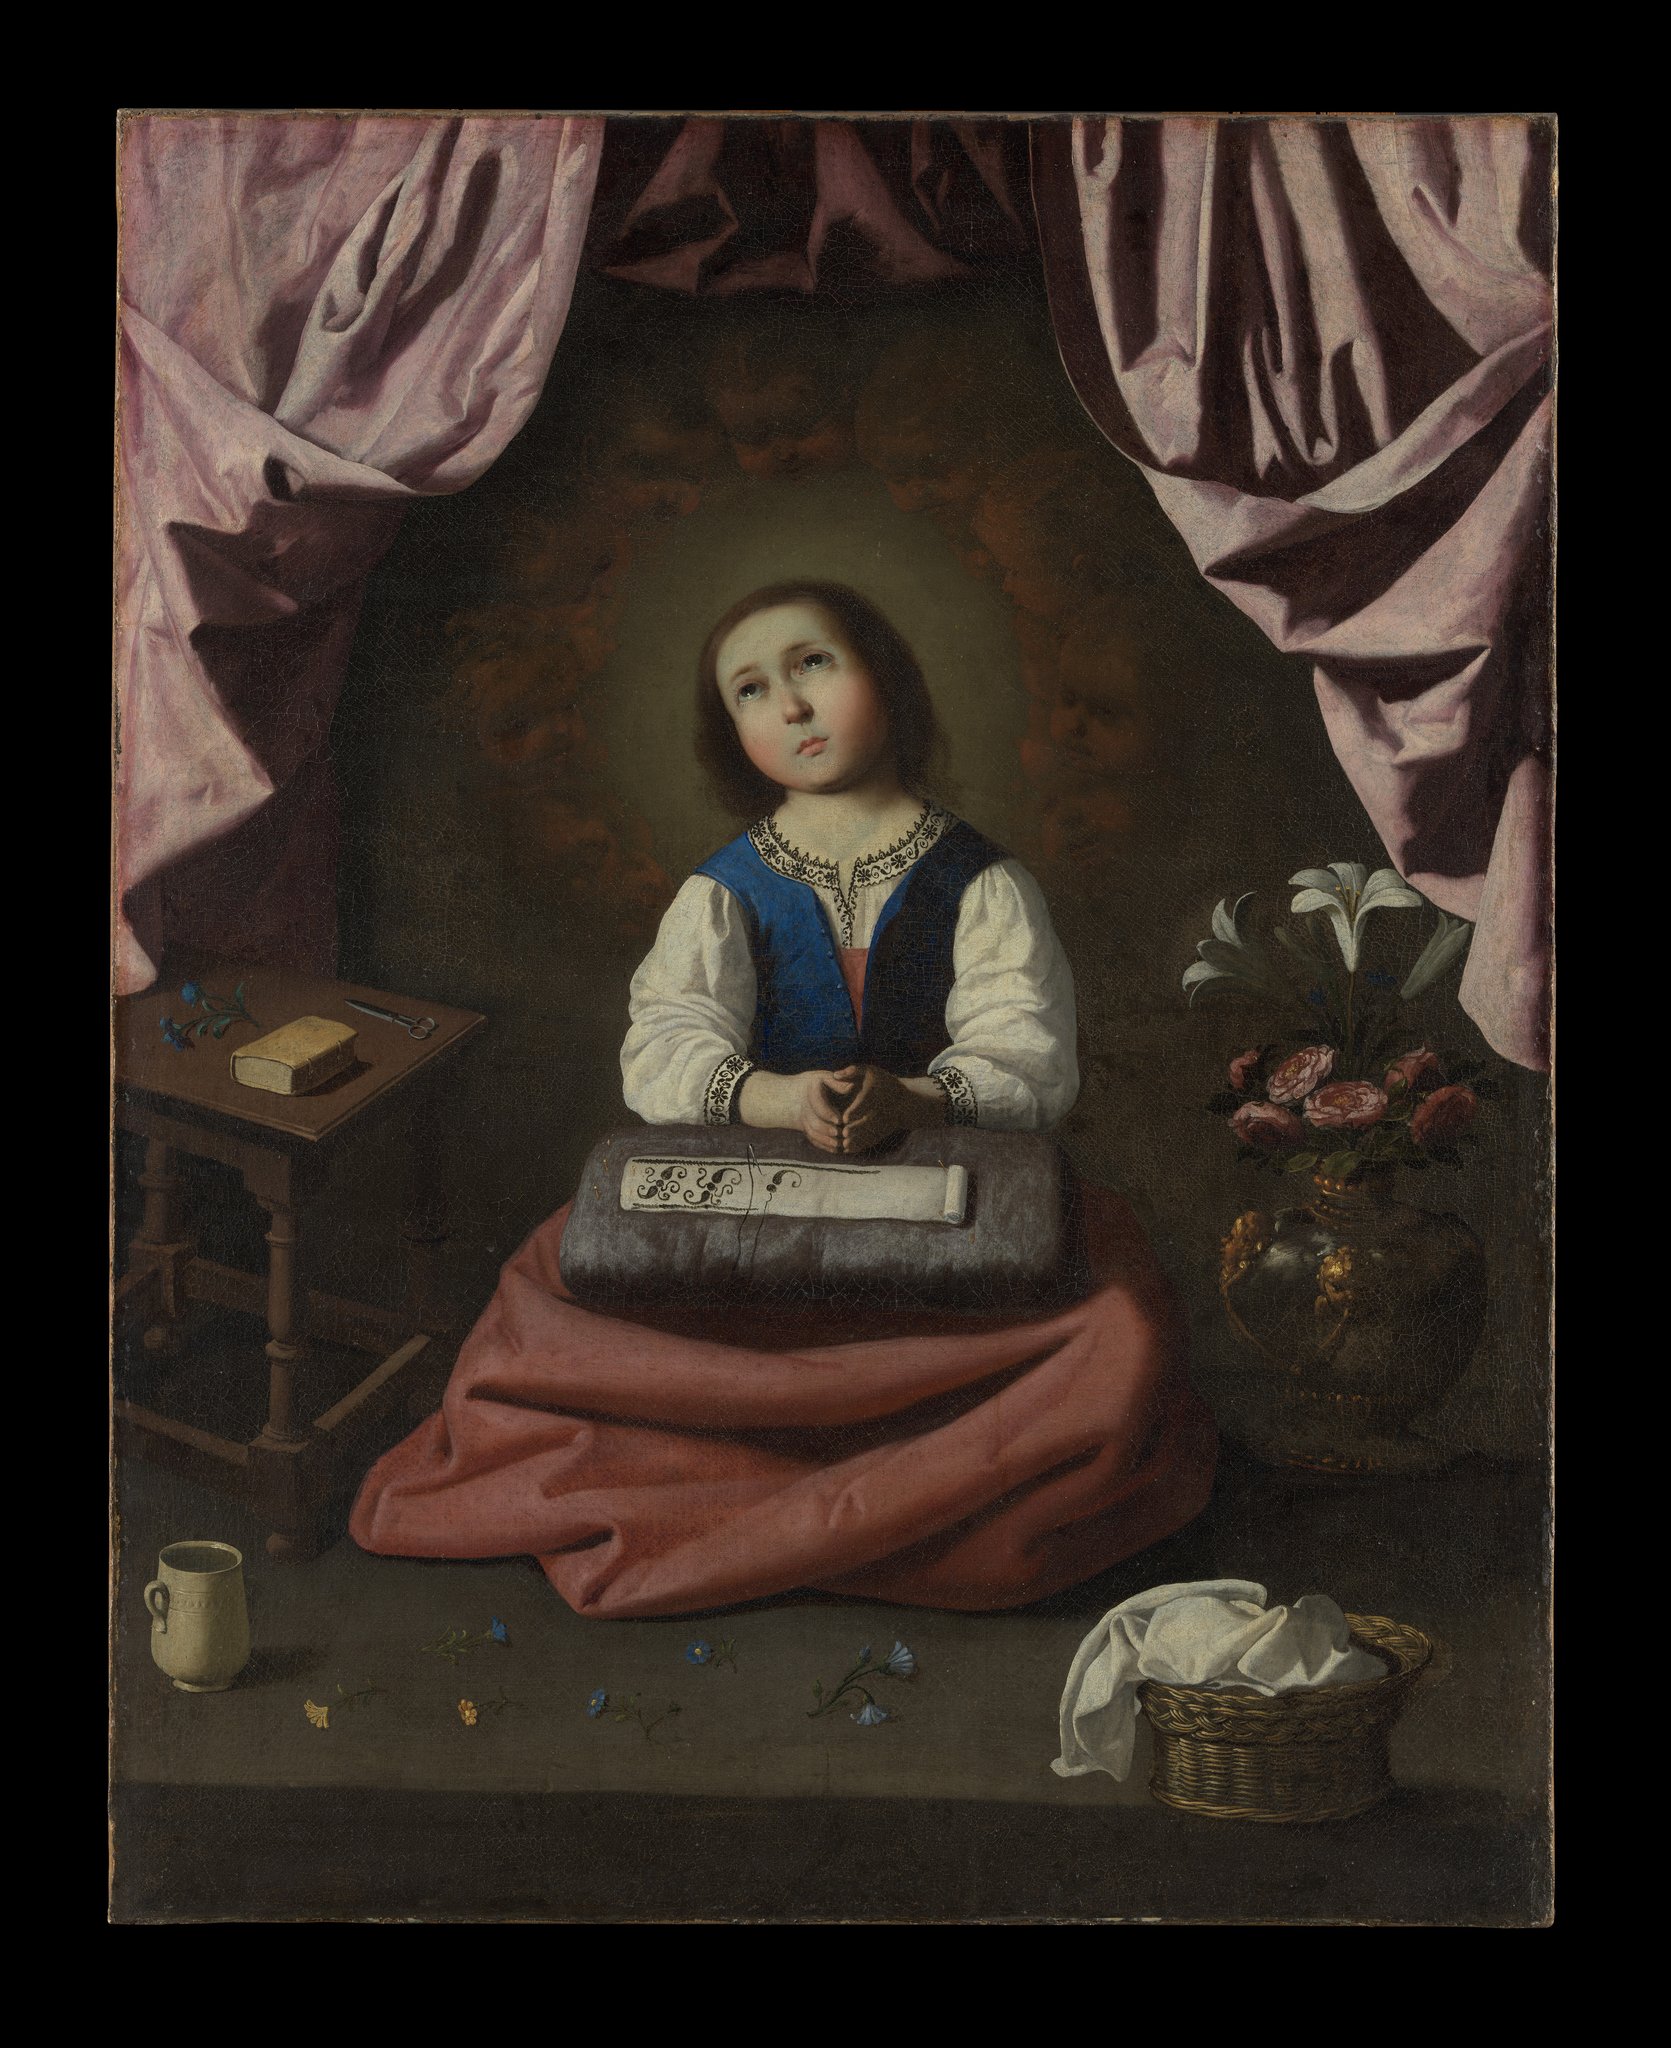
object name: painting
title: The Young Virgin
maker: francisco de zurbarán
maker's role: artist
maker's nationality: spanish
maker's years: 1598-1664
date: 1632-1633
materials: canvas, oil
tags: lilies,virgin mary,sewing